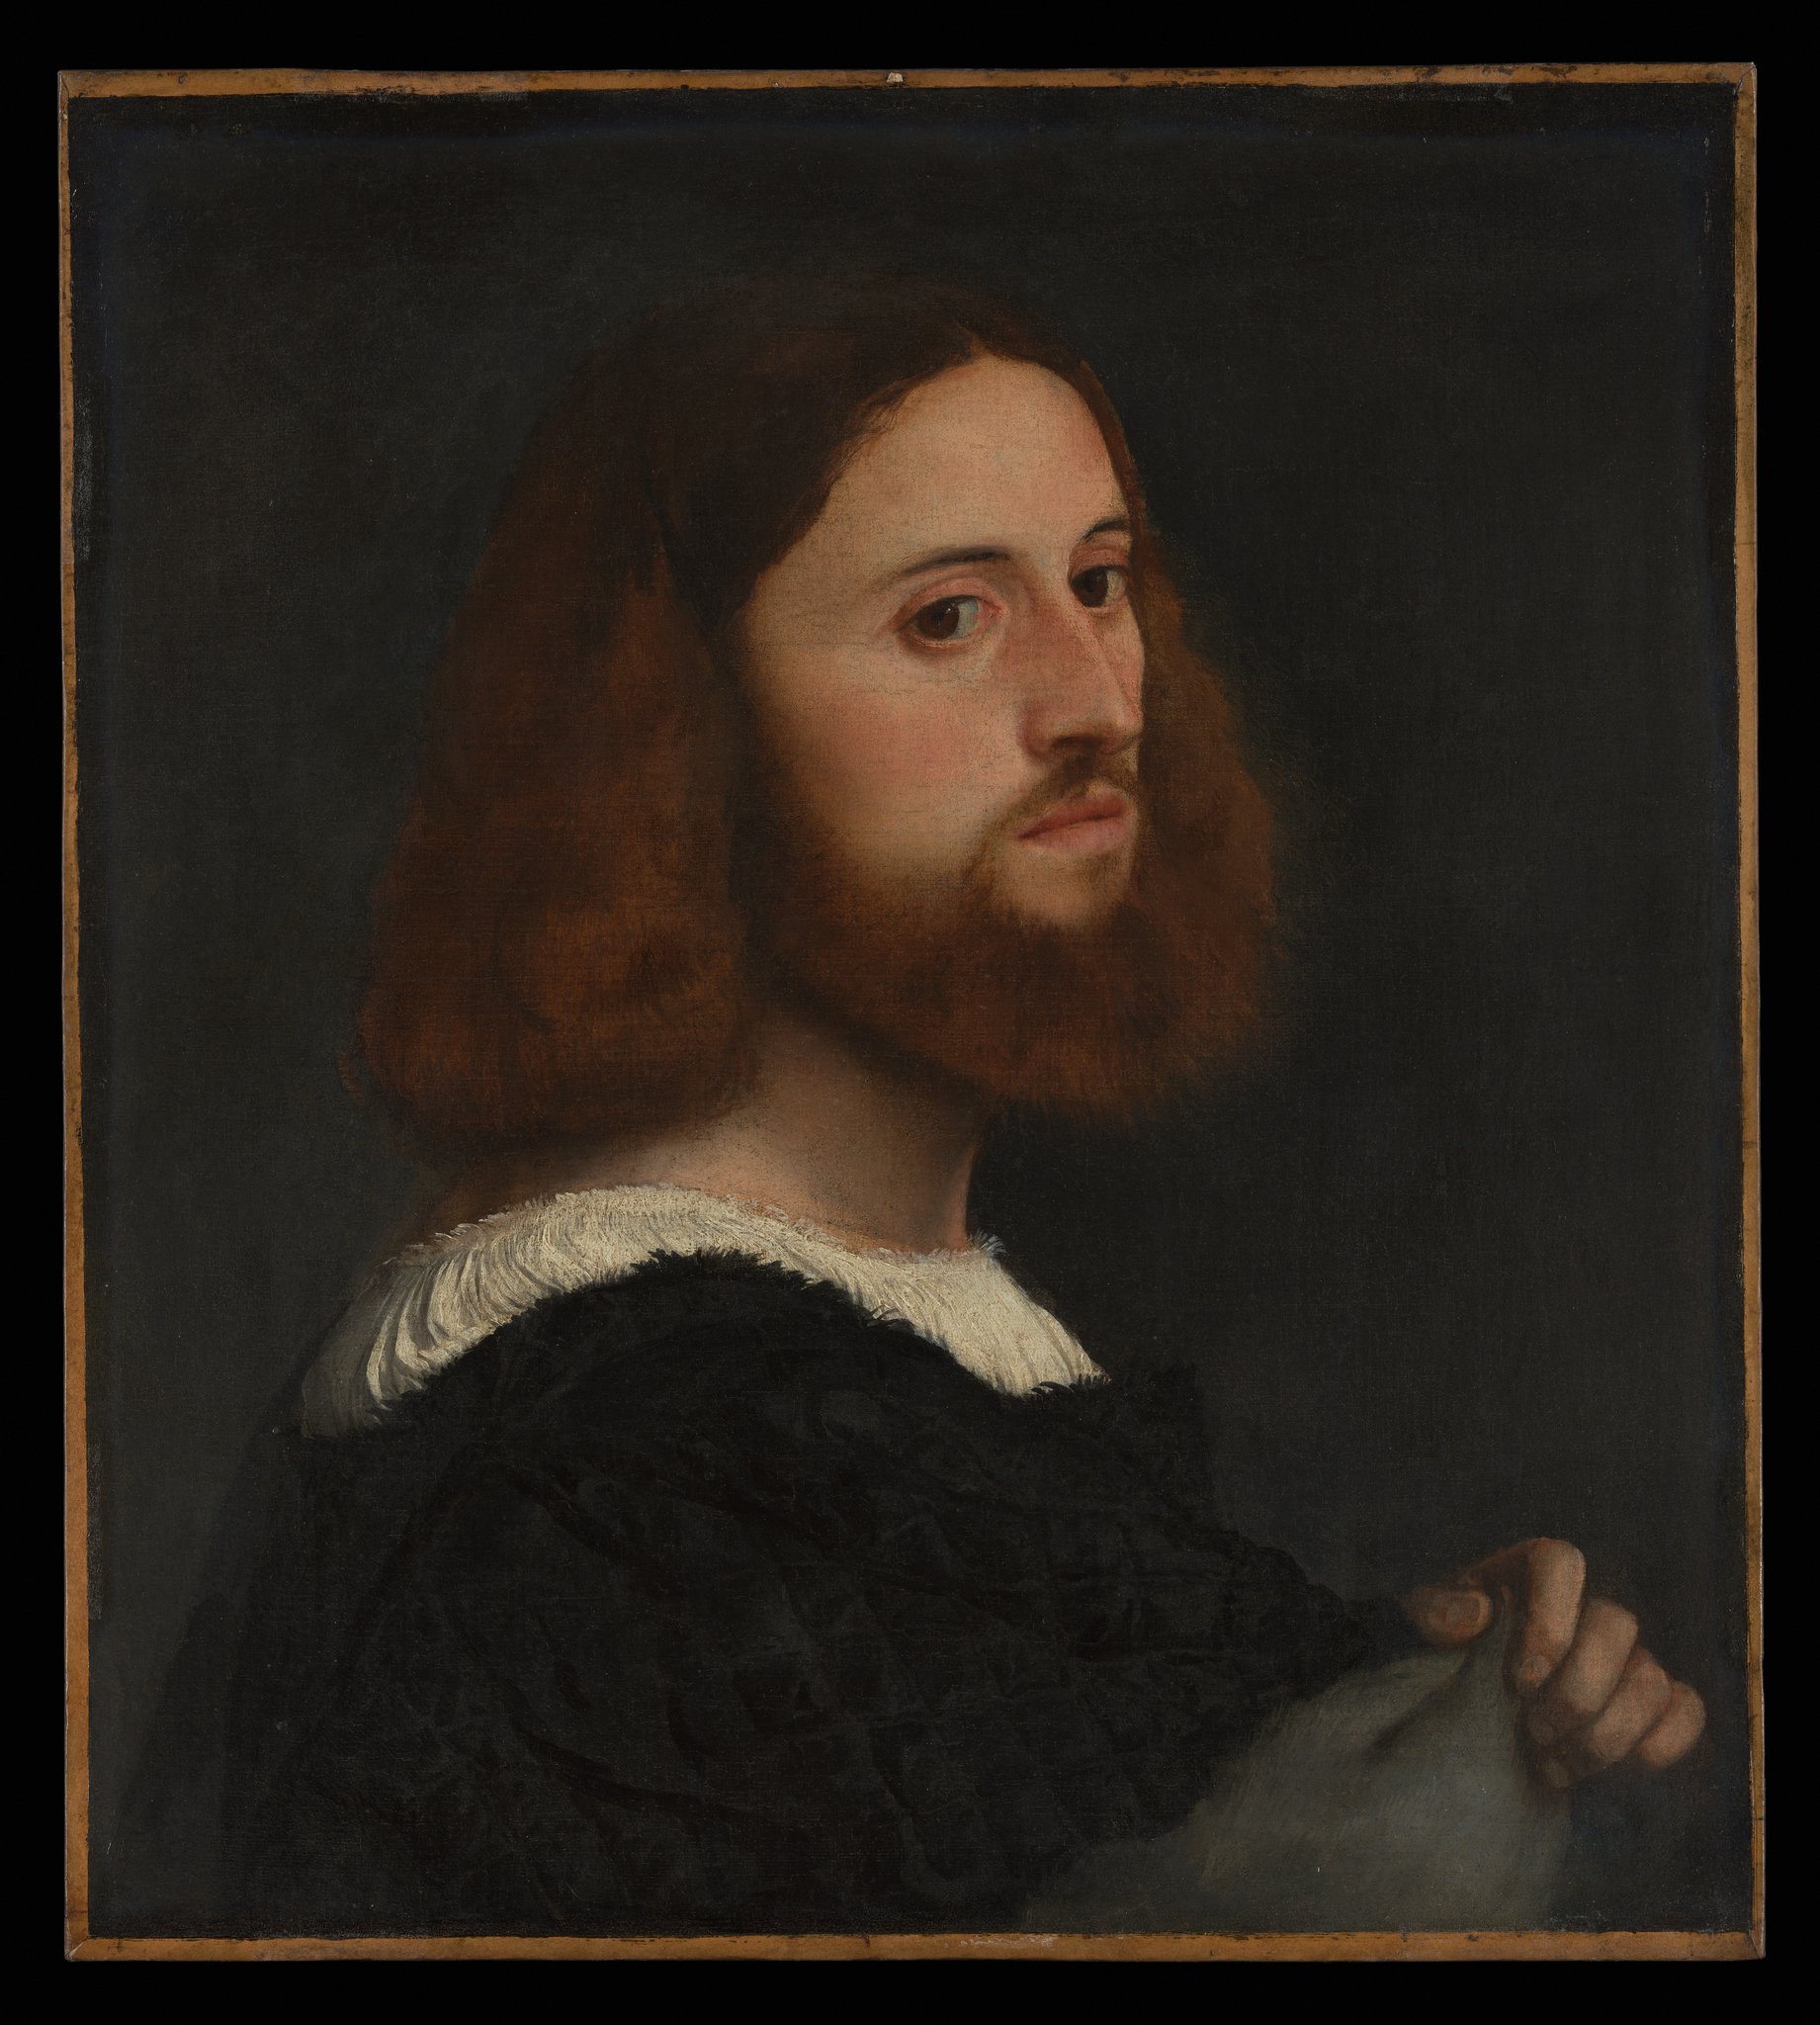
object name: painting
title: Portrait of a Man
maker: titian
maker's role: artist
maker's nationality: italian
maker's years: 1485-1576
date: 1515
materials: canvas, oil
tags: men,portraits